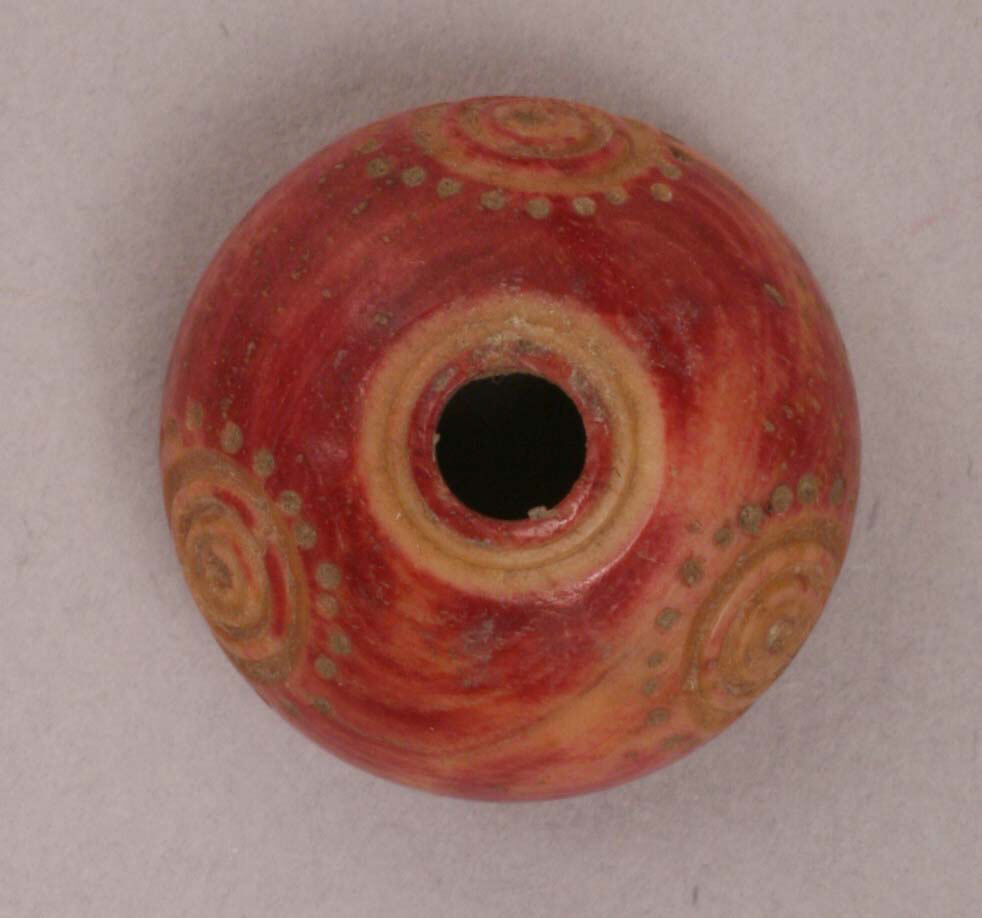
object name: button or bead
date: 801-1000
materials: bone, paint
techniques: incising, inlay, tinting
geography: iran